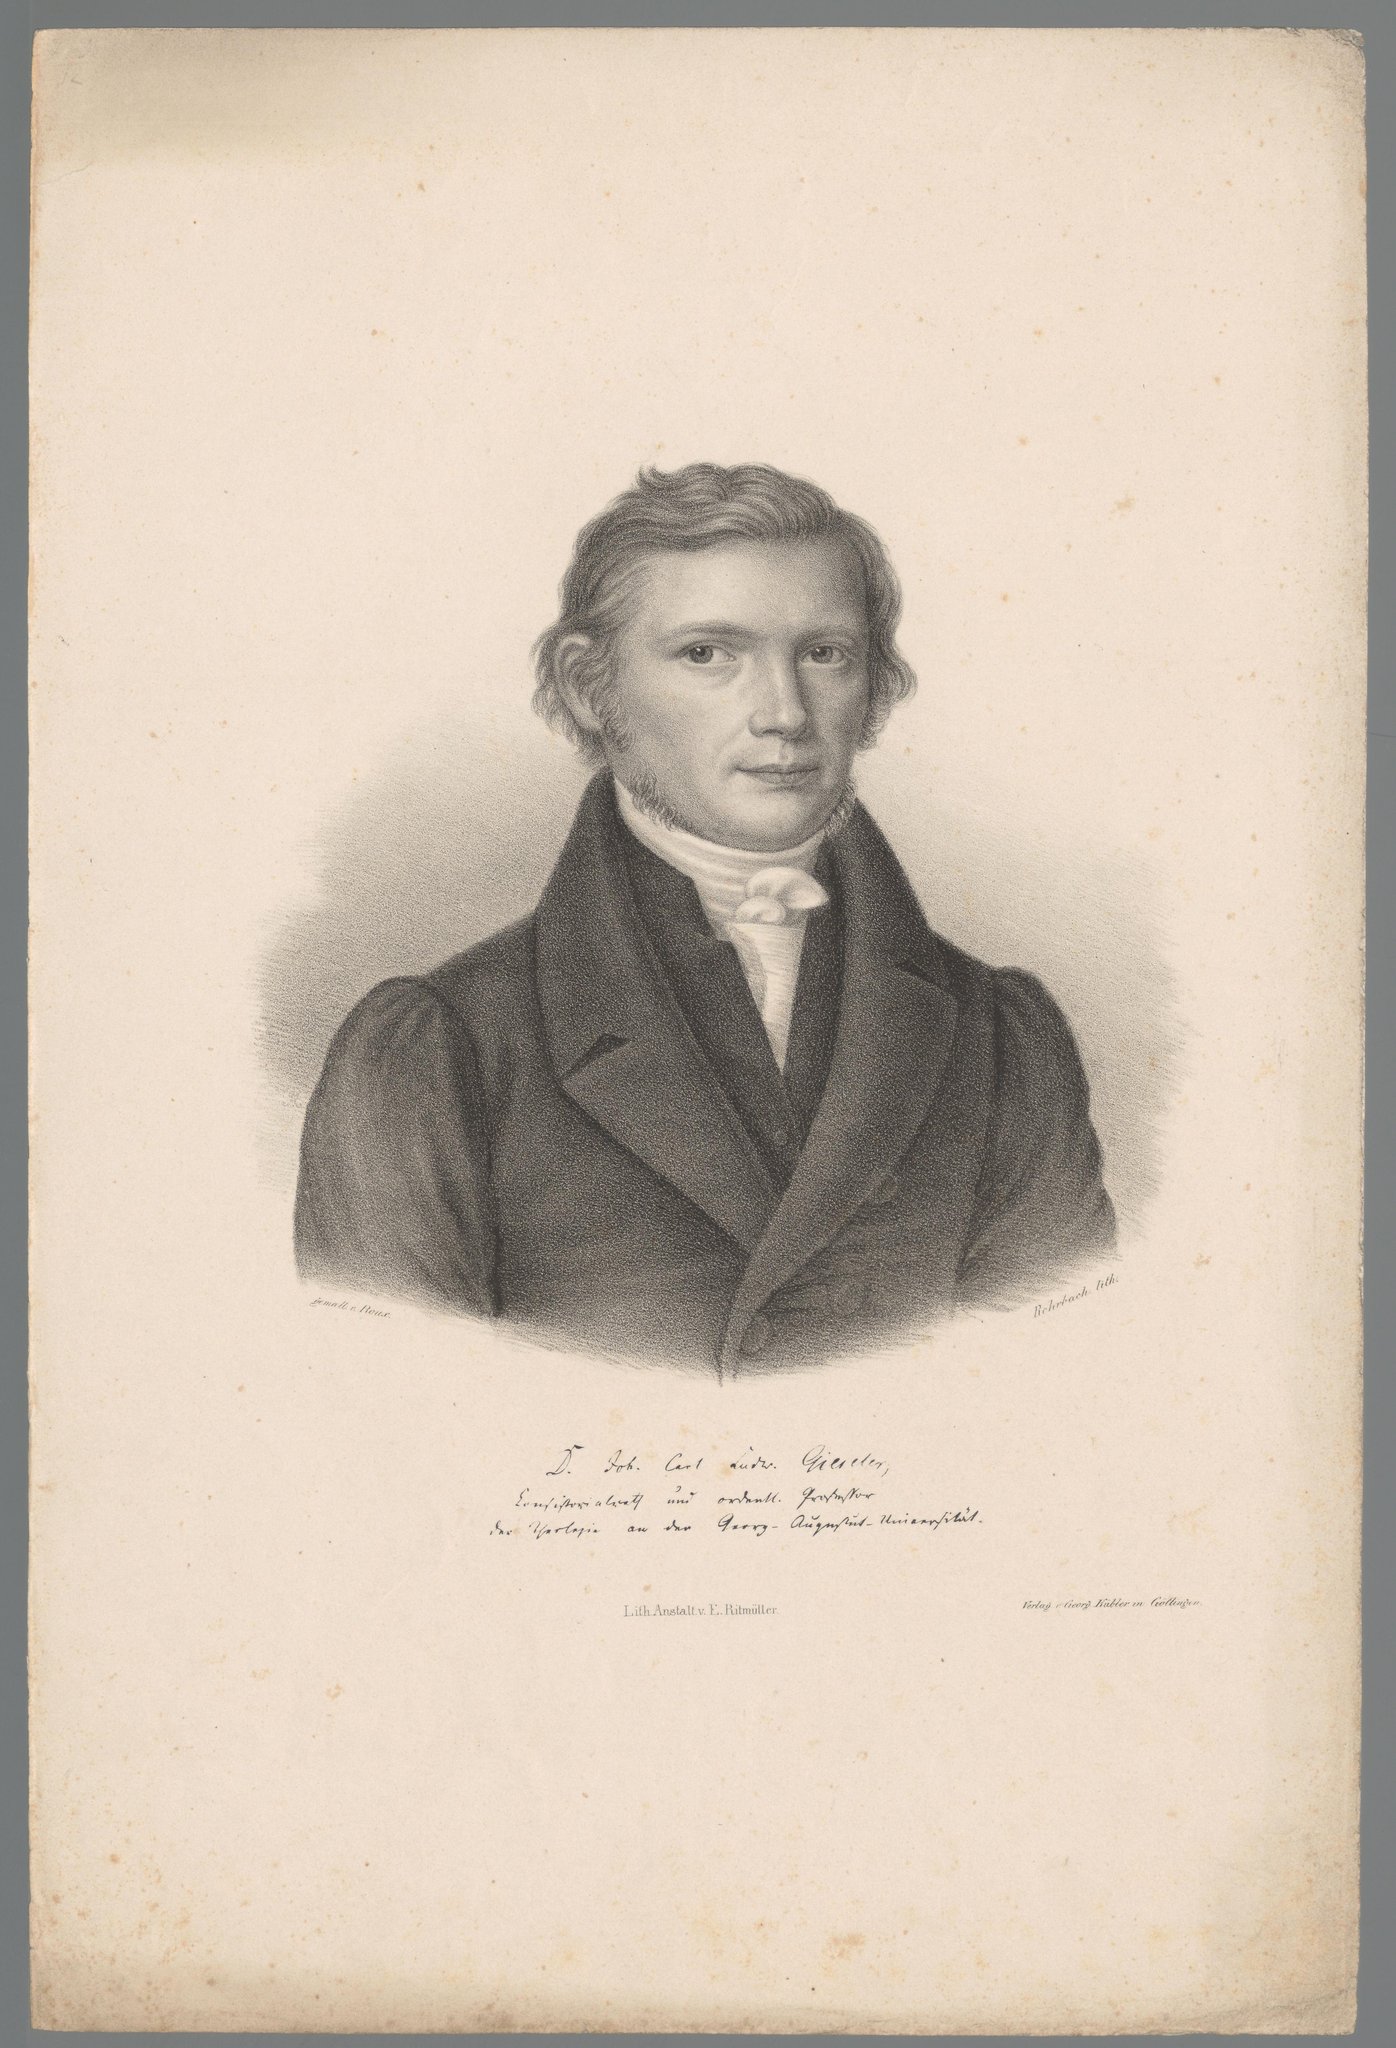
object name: print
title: Portret van Johann Karl Ludwig Gieseler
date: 1827-1830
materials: paper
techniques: lithograph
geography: gottingen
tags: history and archaeology (+ portrait of scholar, scientist), historical persons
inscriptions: collector's mark: Lugt 2228